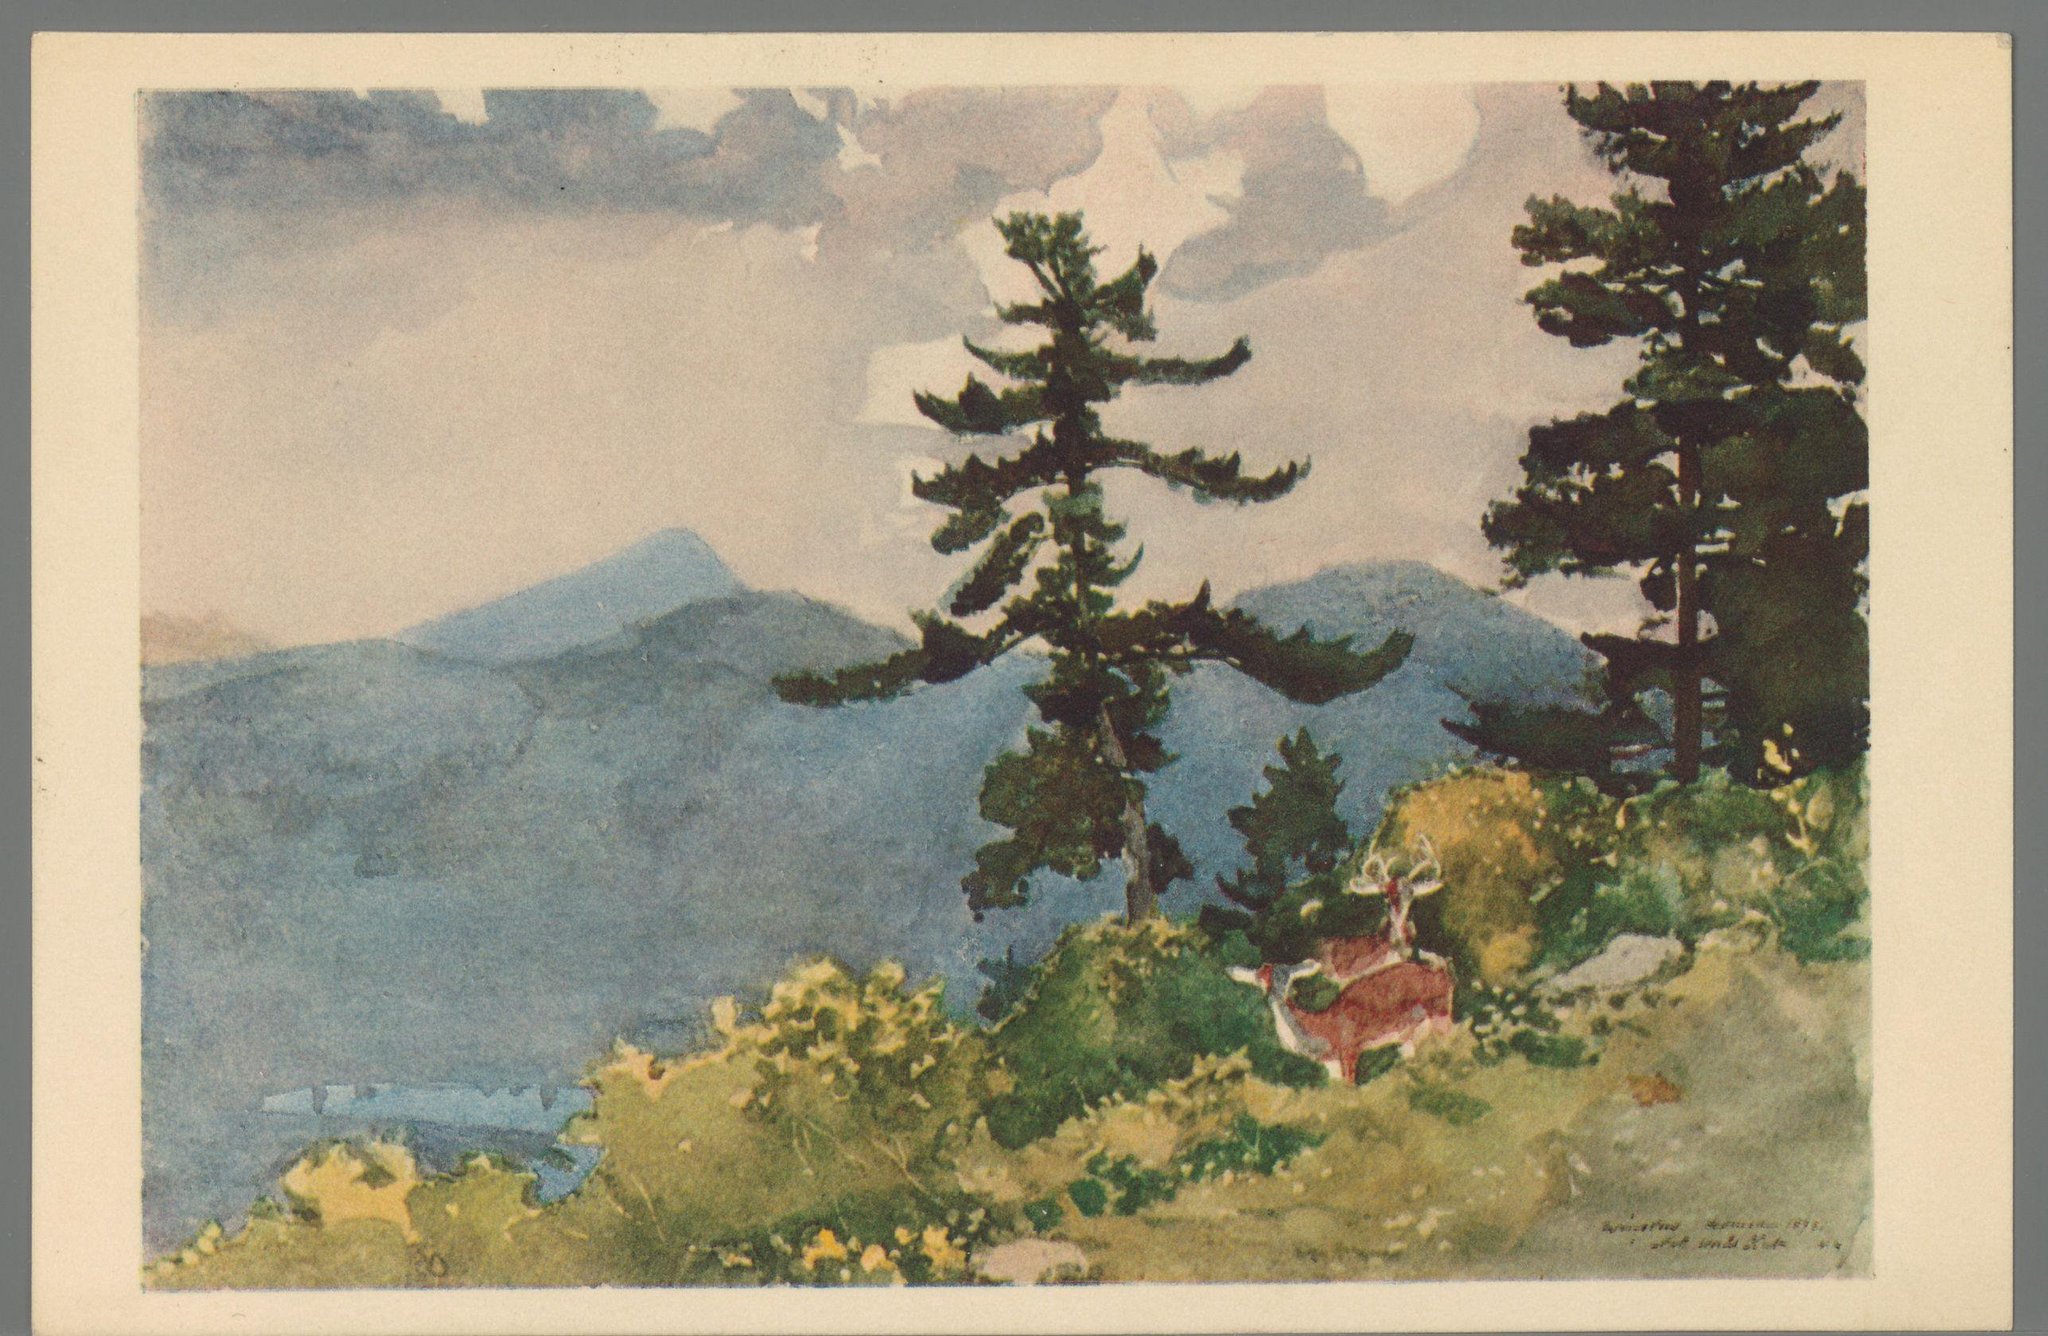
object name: ansichtkaart, prentbriefkaart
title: North Woods Club, Adirondacks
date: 1933-1940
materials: cardboard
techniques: photograph, lithograph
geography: chicago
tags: hoofed animals: deer, mountains